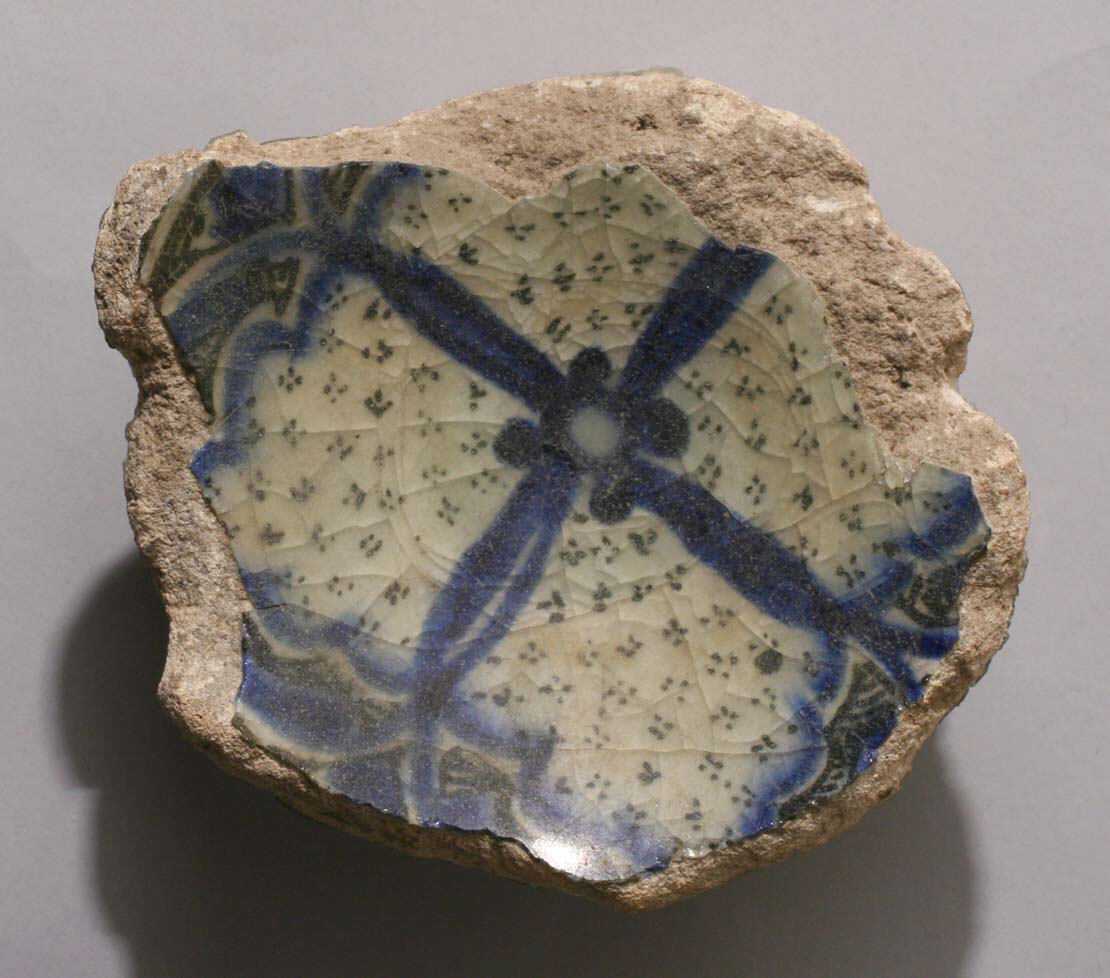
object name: fragment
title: Ceramic Fragment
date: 1301-1400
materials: glaze, stonepaste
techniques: painting, polychrome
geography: syria